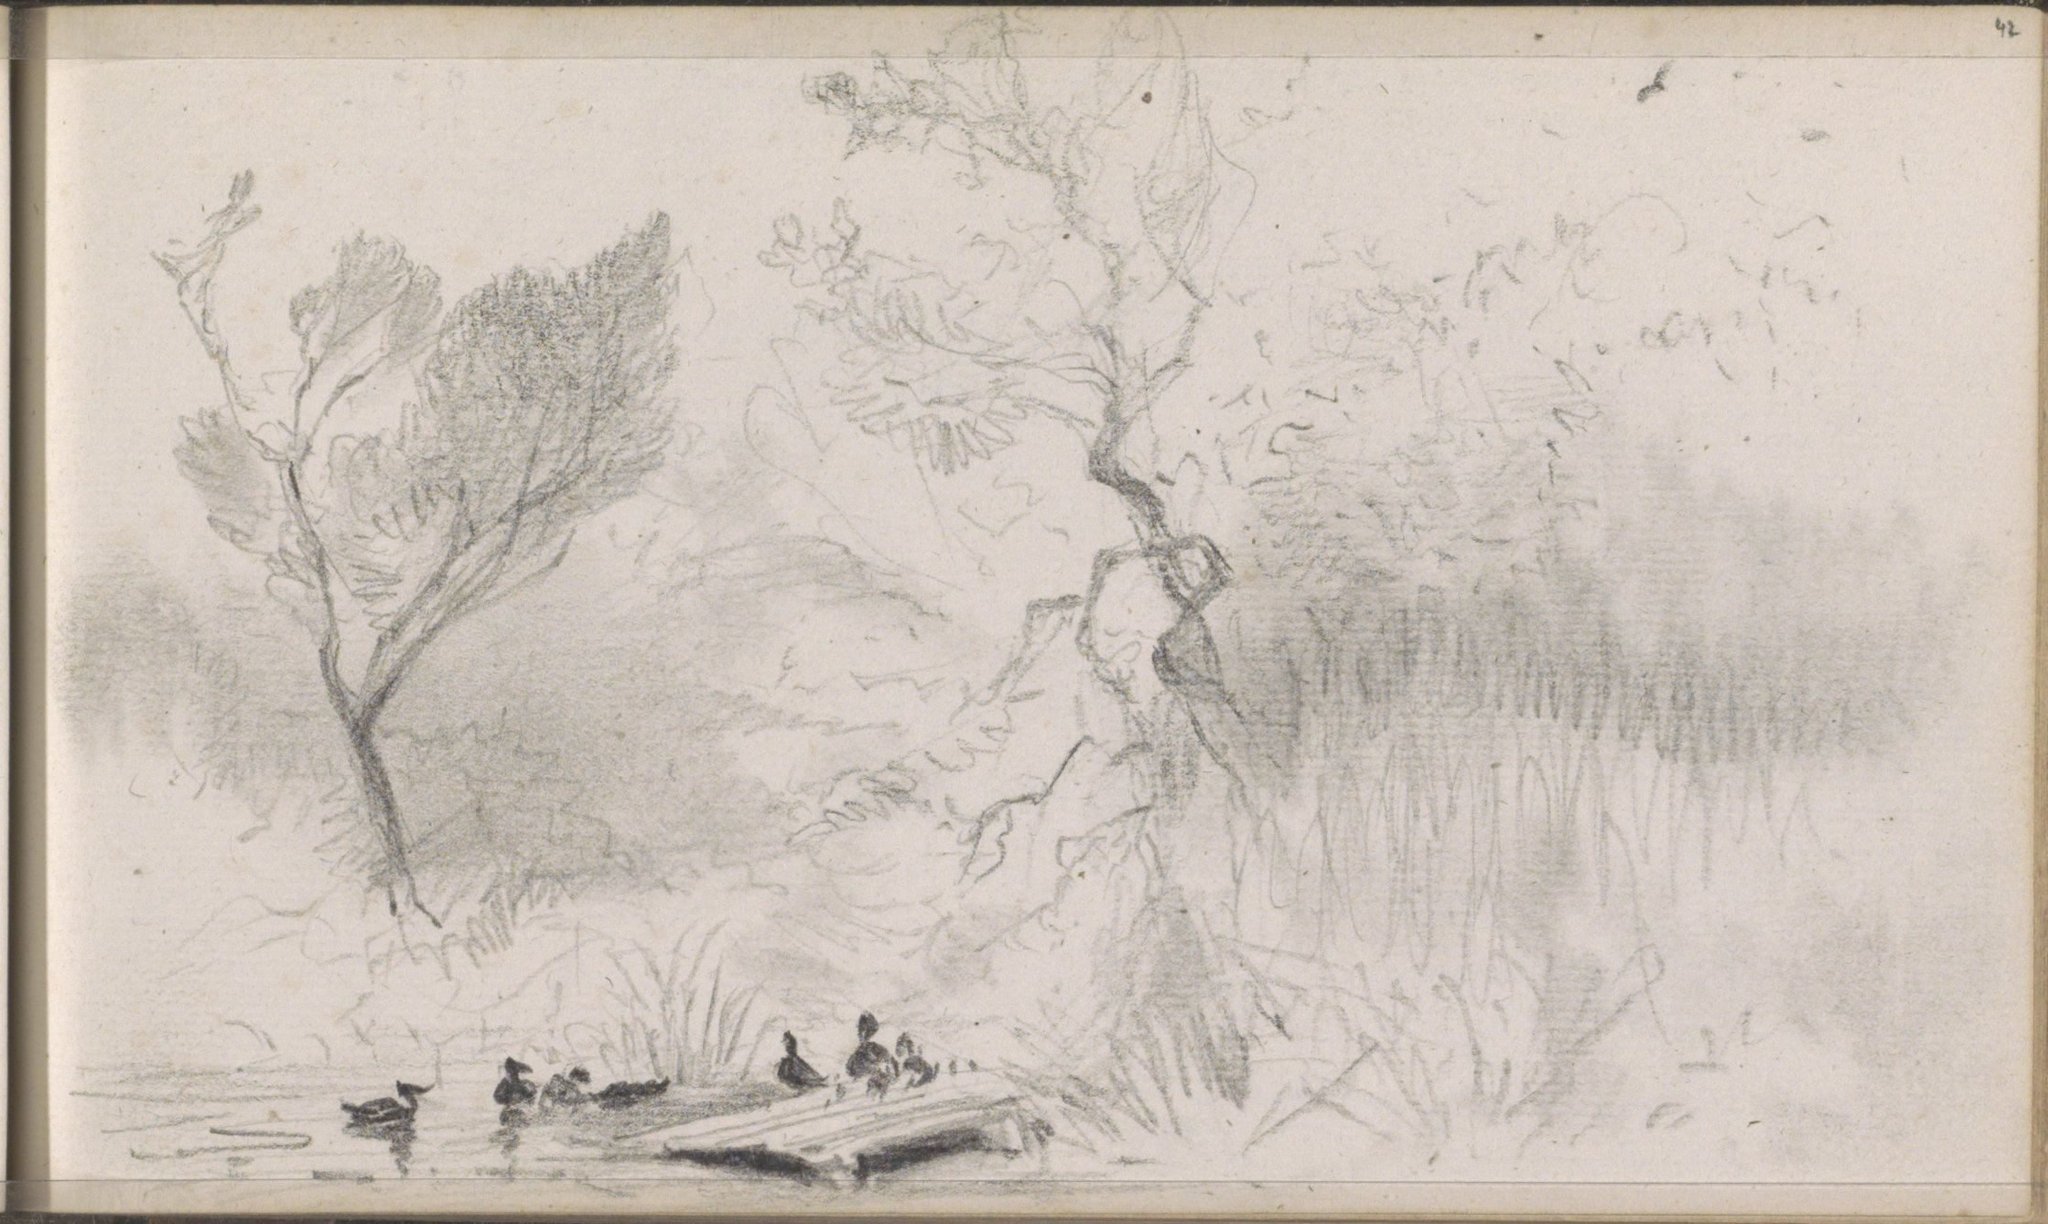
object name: sketchbook leaf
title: Eenden op en bij een stuk hout aan de waterkant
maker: johannes tavenraat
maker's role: draughtsman, painter, print maker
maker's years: 1809-1881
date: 1864-1880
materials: paper, pencil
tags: river bank, water-birds: duck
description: Blad 42 recto uit een schetsboek met 98 bladen.